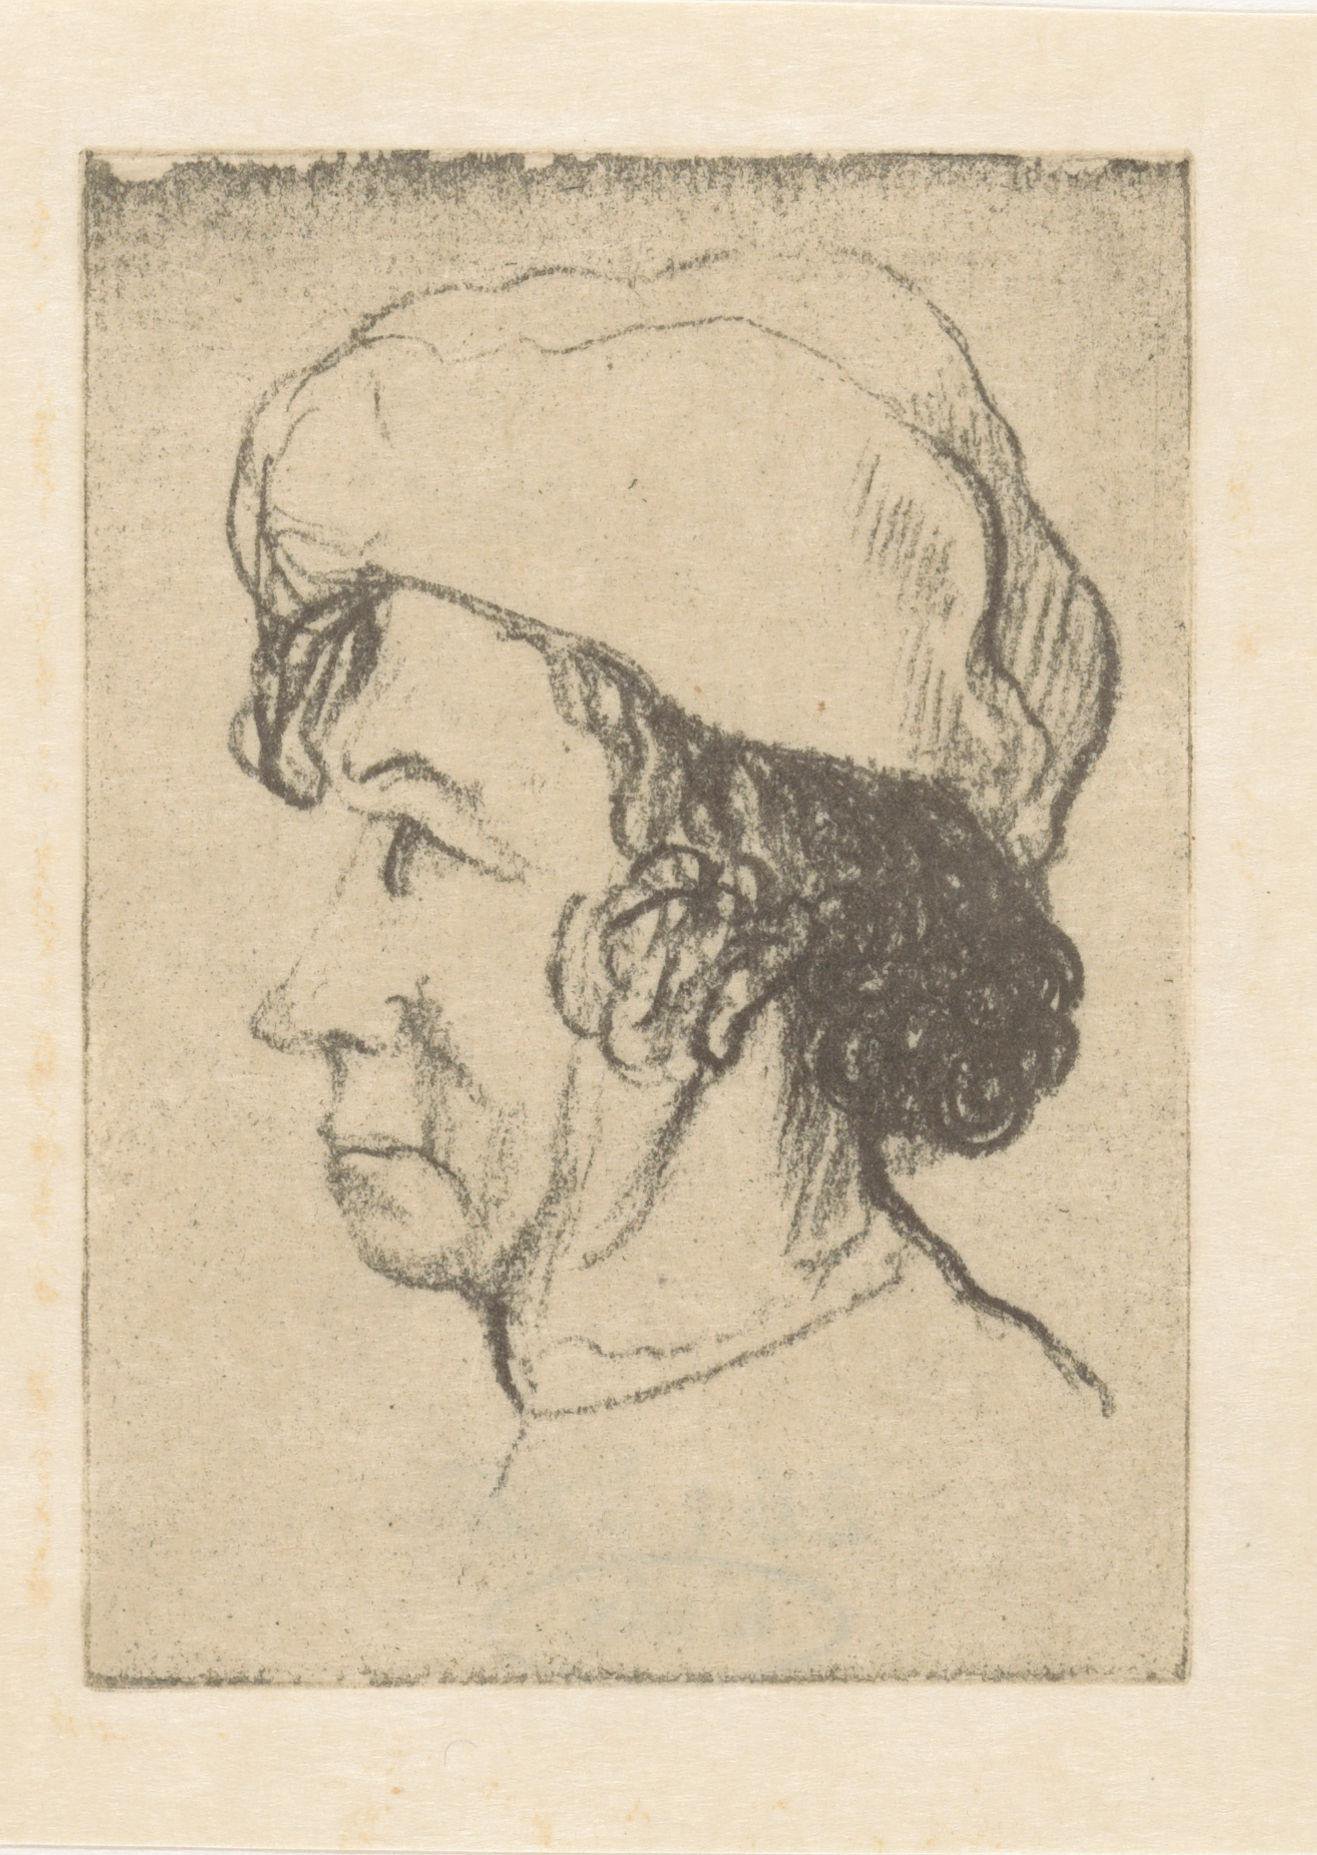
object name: print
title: Vrouw met hoed en profil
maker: marius holleman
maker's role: draughtsman, print maker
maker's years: 1878-1926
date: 1904-1926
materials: paper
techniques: etching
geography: groningen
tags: head-gear: hat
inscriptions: collector's mark: Lugt 2228